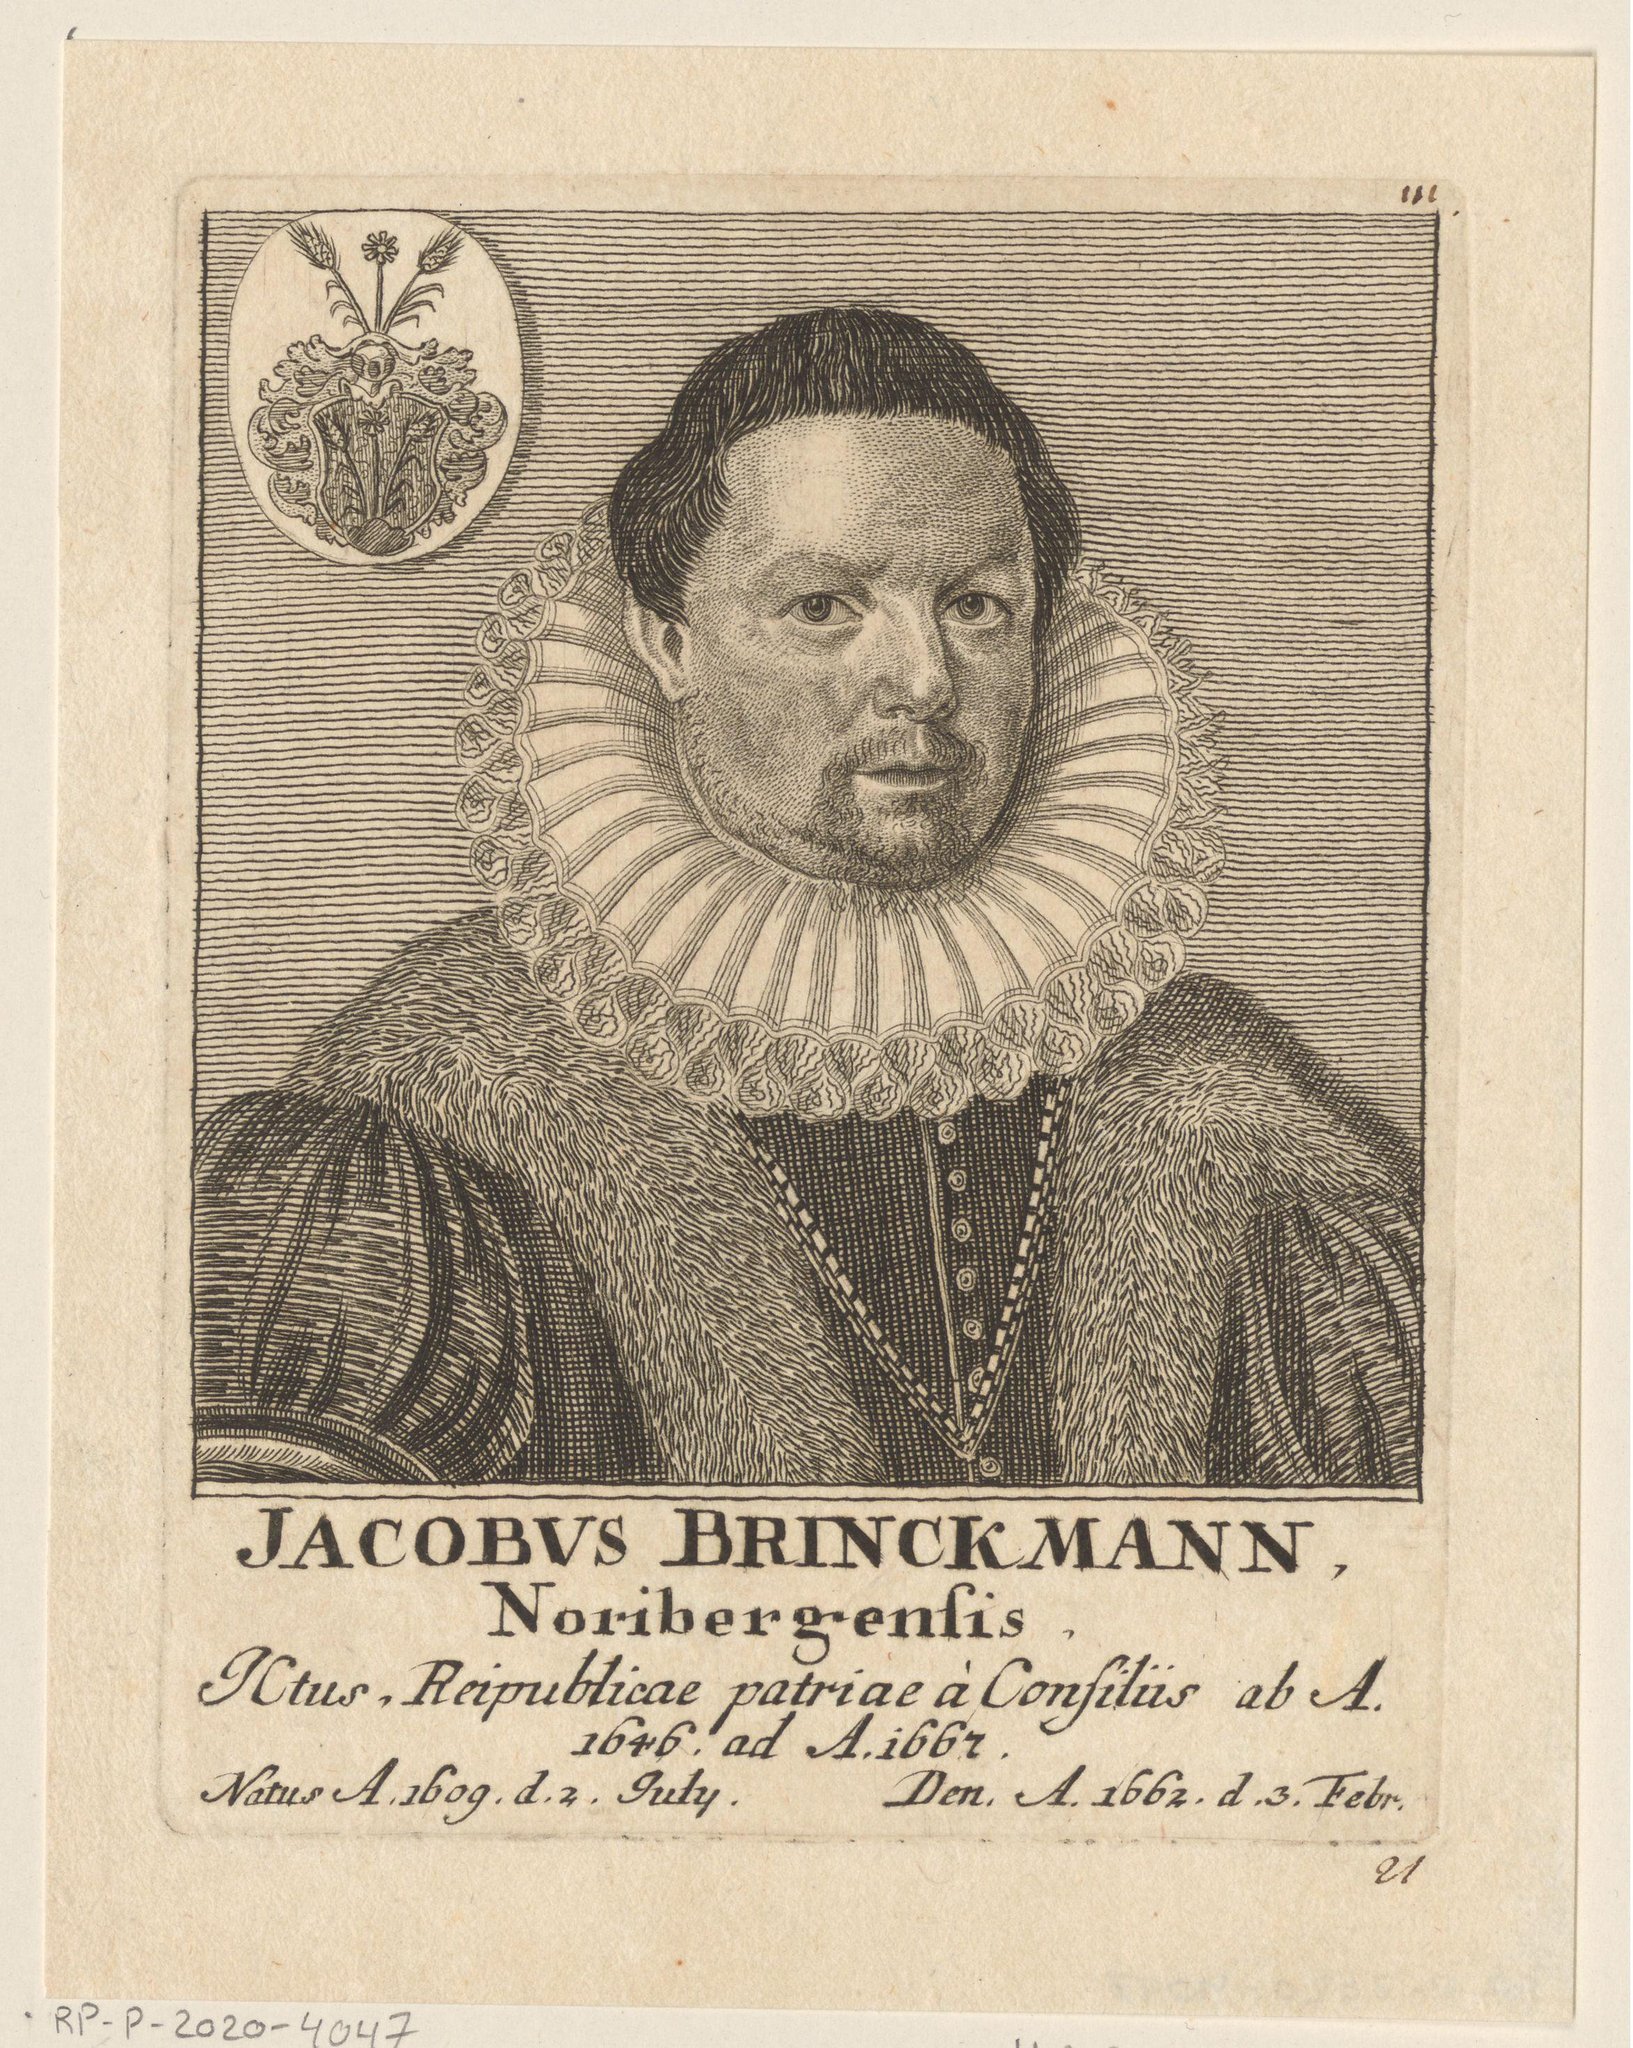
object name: print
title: Portret van Jacob Brinckmann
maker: Anonymous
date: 1700-1749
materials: paper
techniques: engraving, etching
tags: historical persons, armorial bearing, heraldry